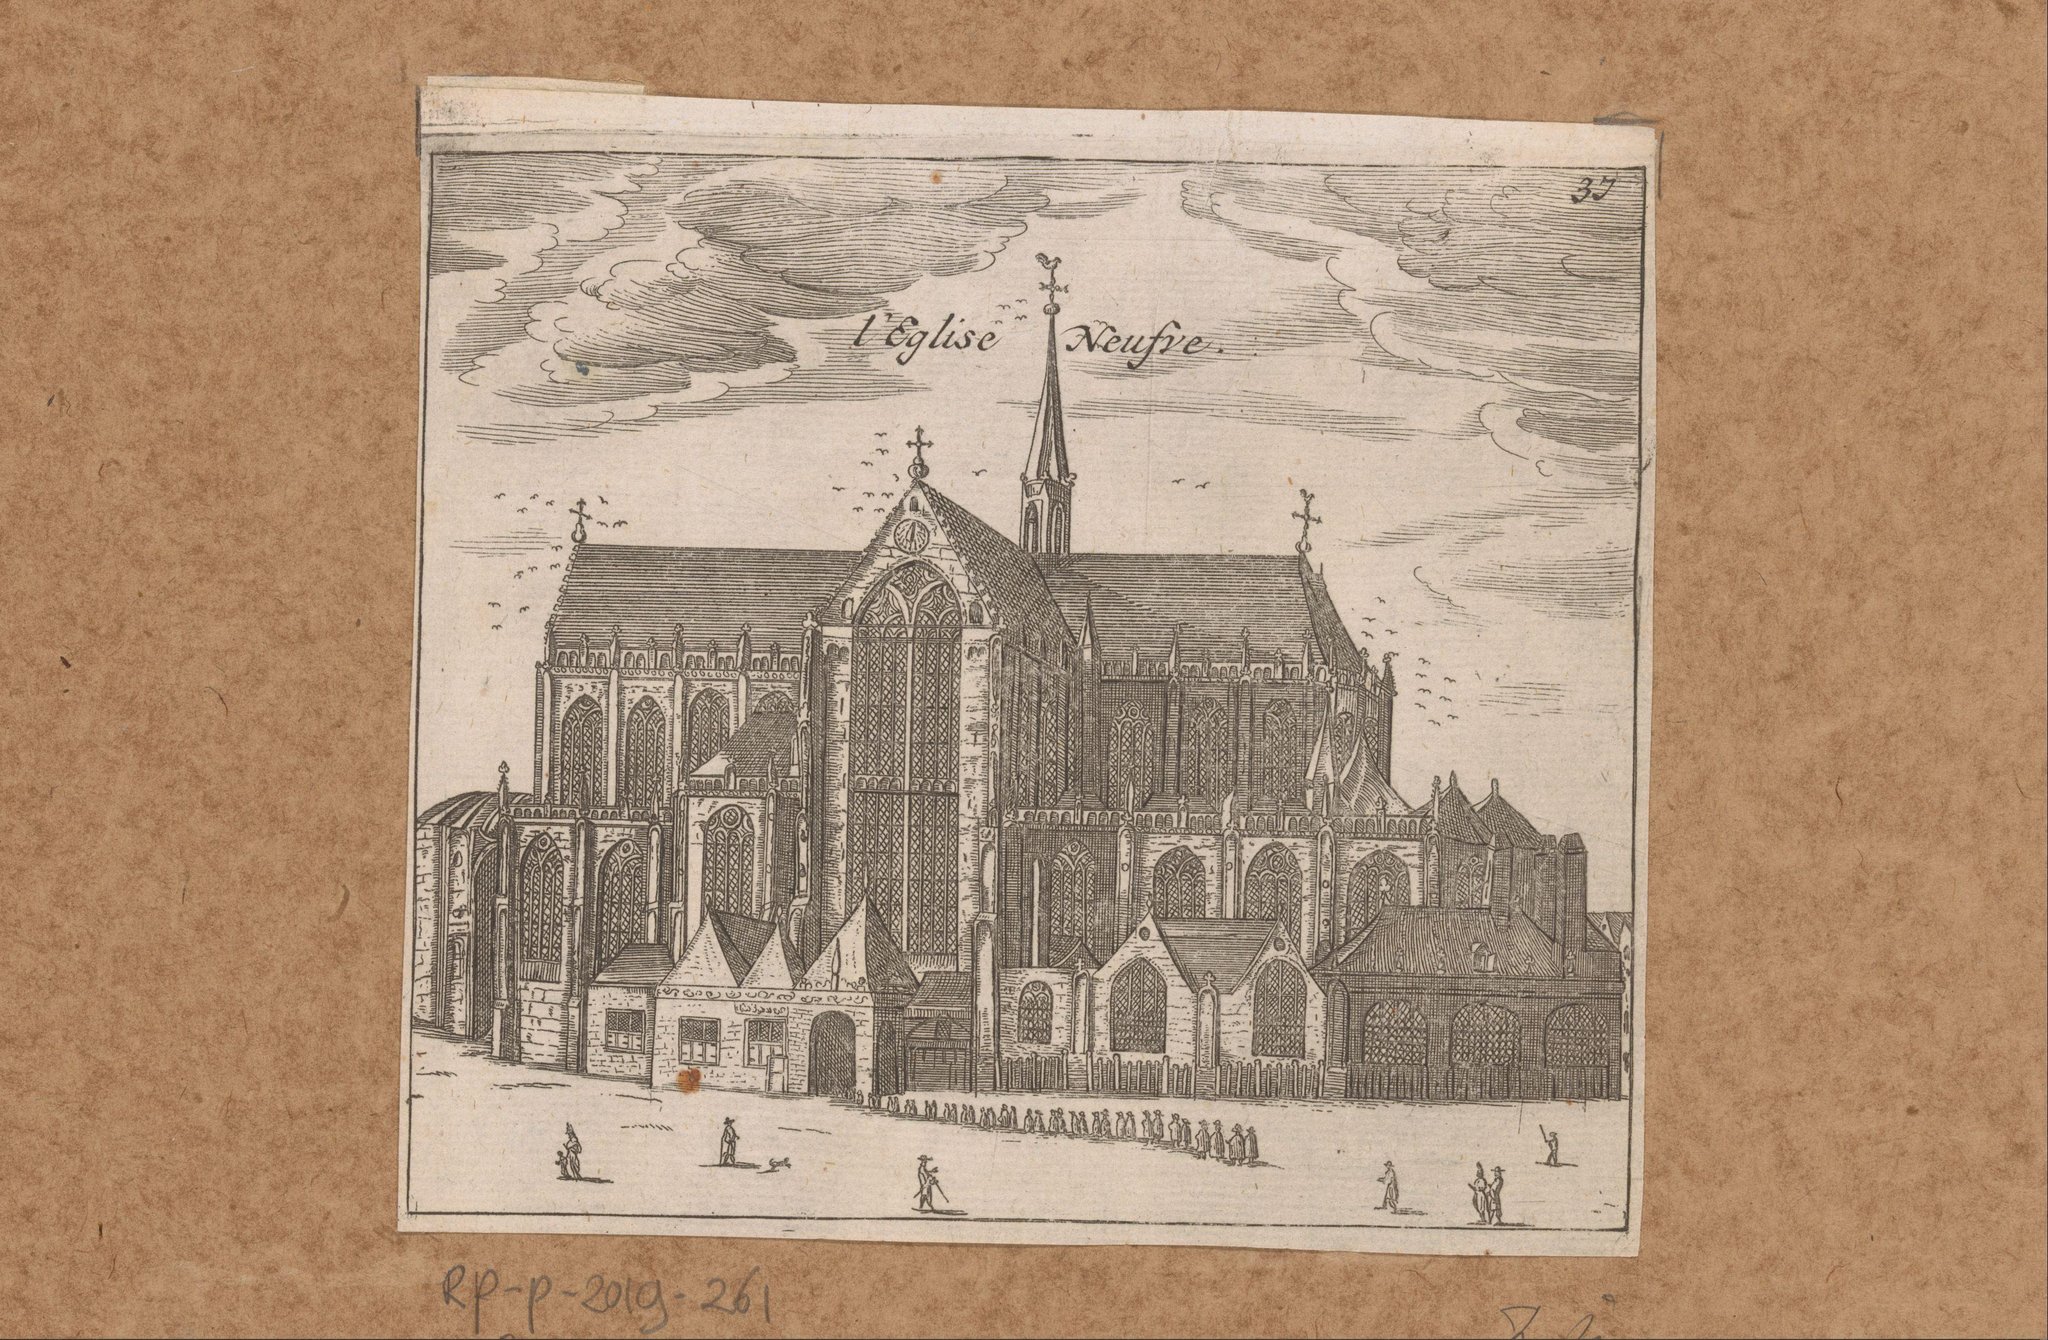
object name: print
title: Gezicht op de Nieuwe Kerk te Amsterdam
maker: Anonymous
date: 1700-1750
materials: paper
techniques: etching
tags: church (exterior), city-view, and landscape with man-made constructions (+ city(-scape) with figures, staffage)